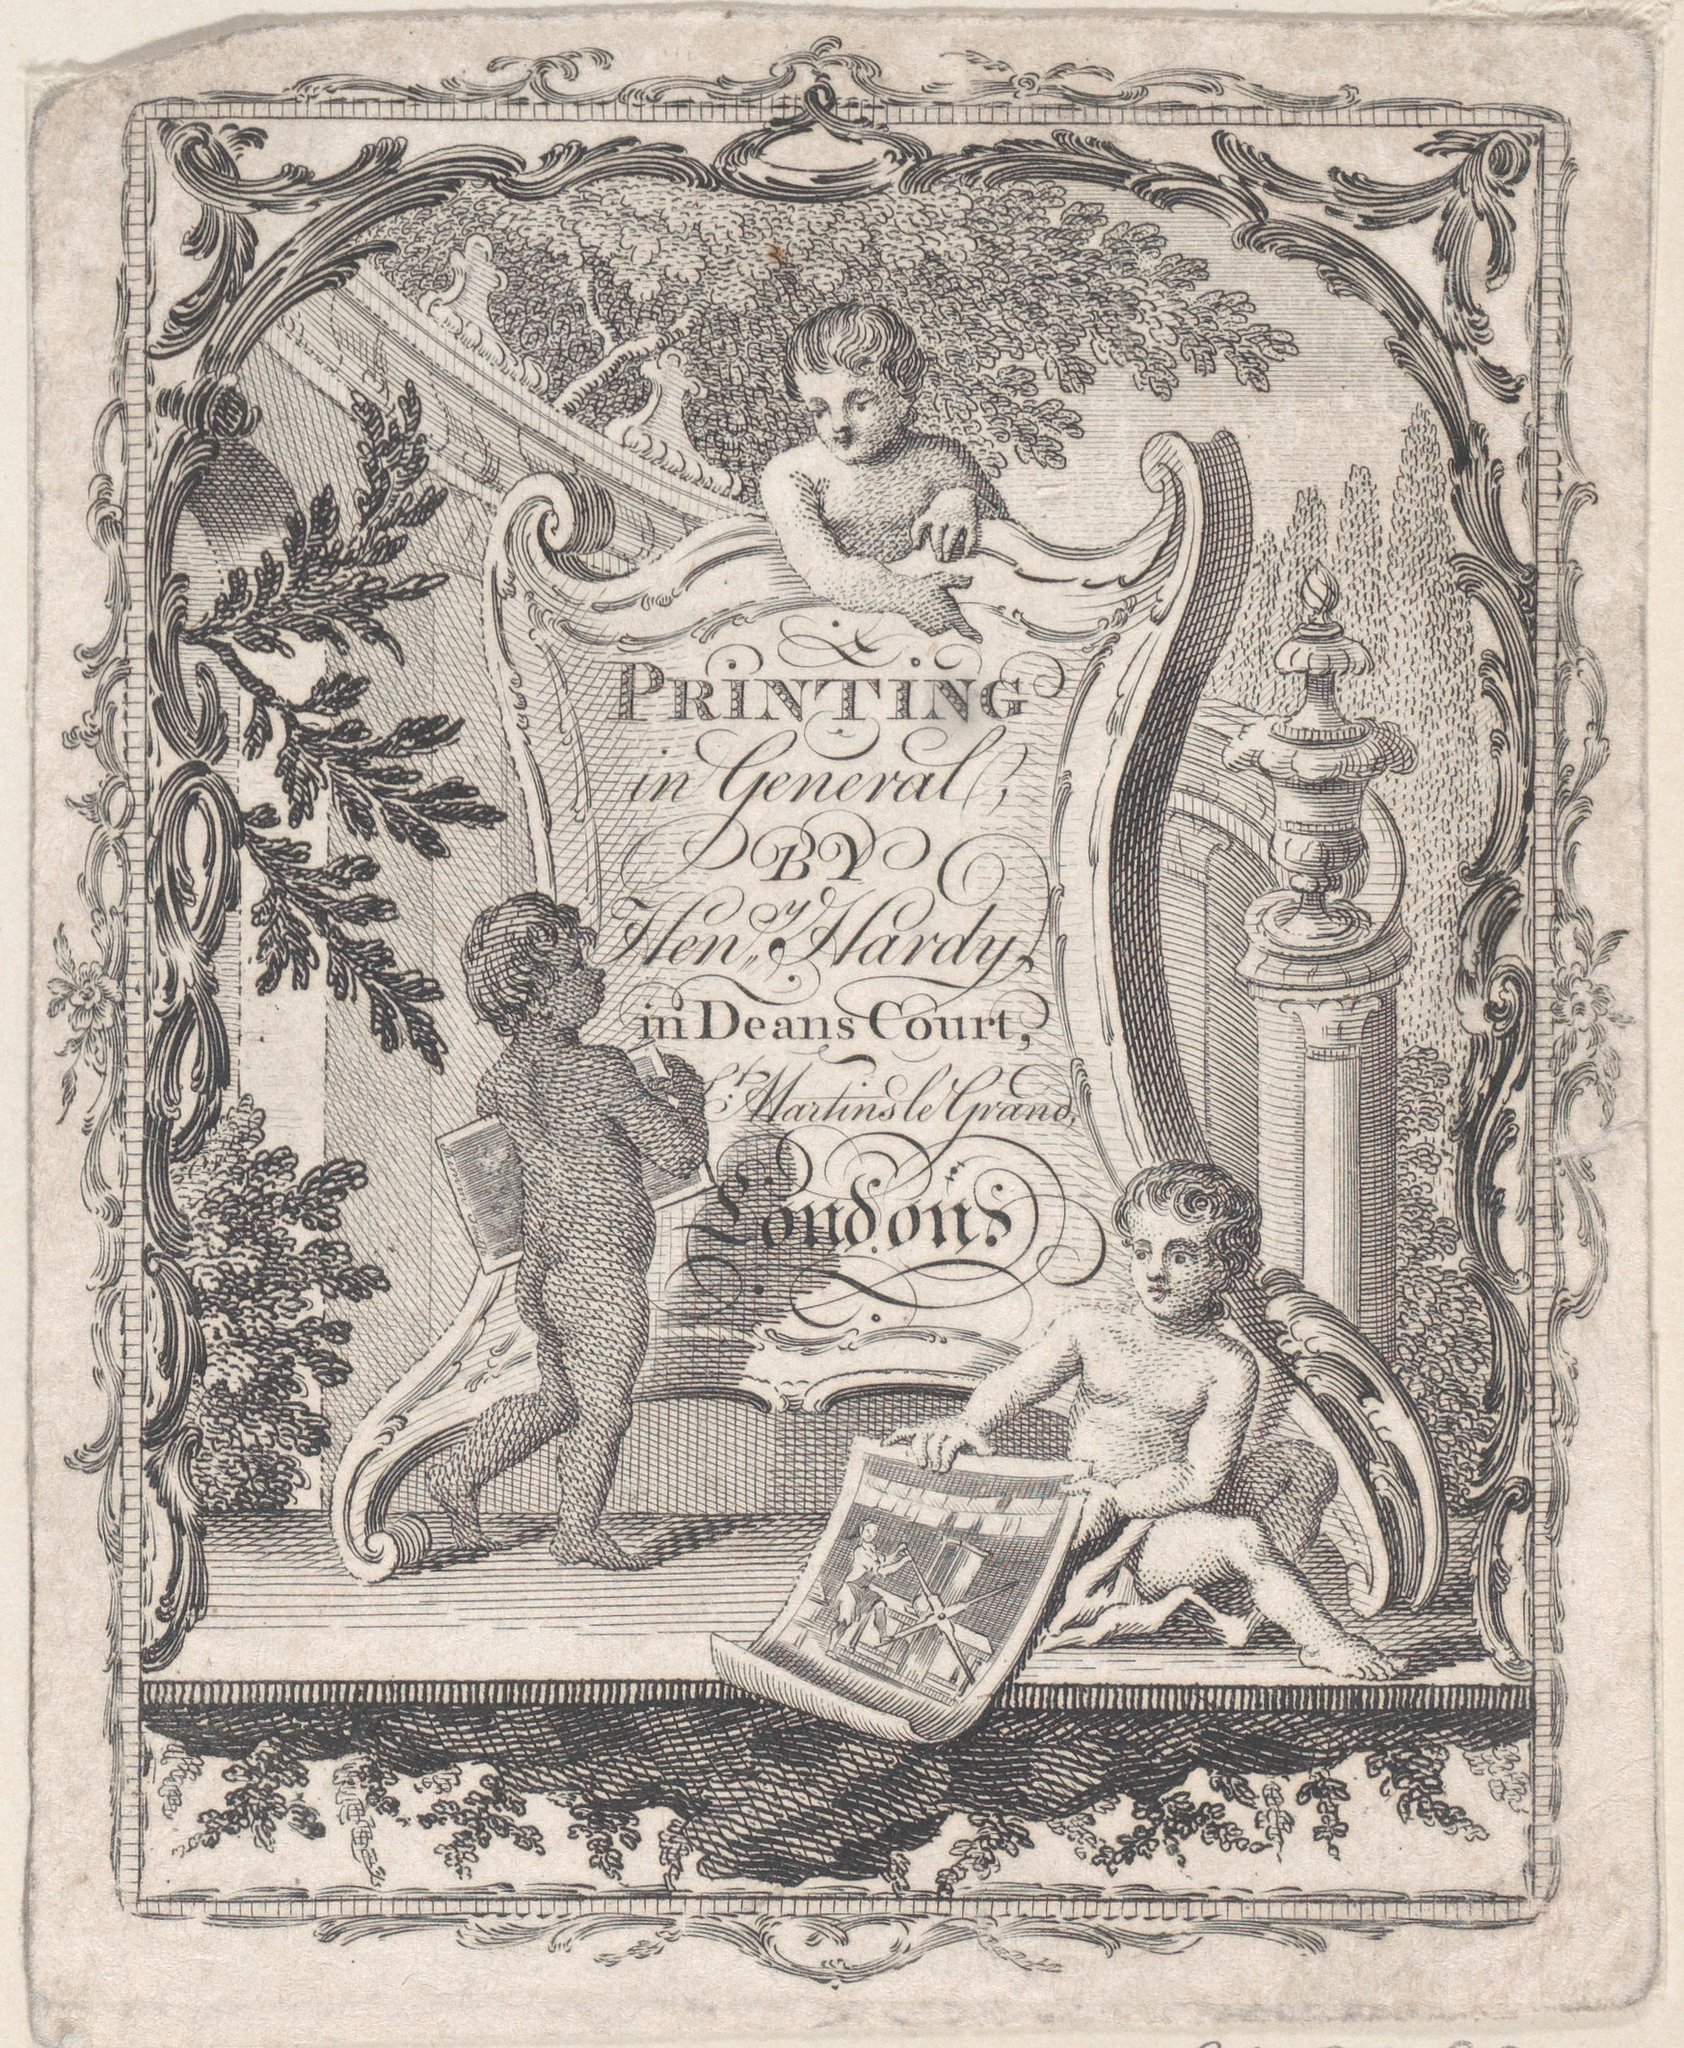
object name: print, trade card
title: Trade card for Henry Hardy, Printer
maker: anonymous, british, 19th century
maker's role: artist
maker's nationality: british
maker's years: 1800-1900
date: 1801-1900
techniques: engraving